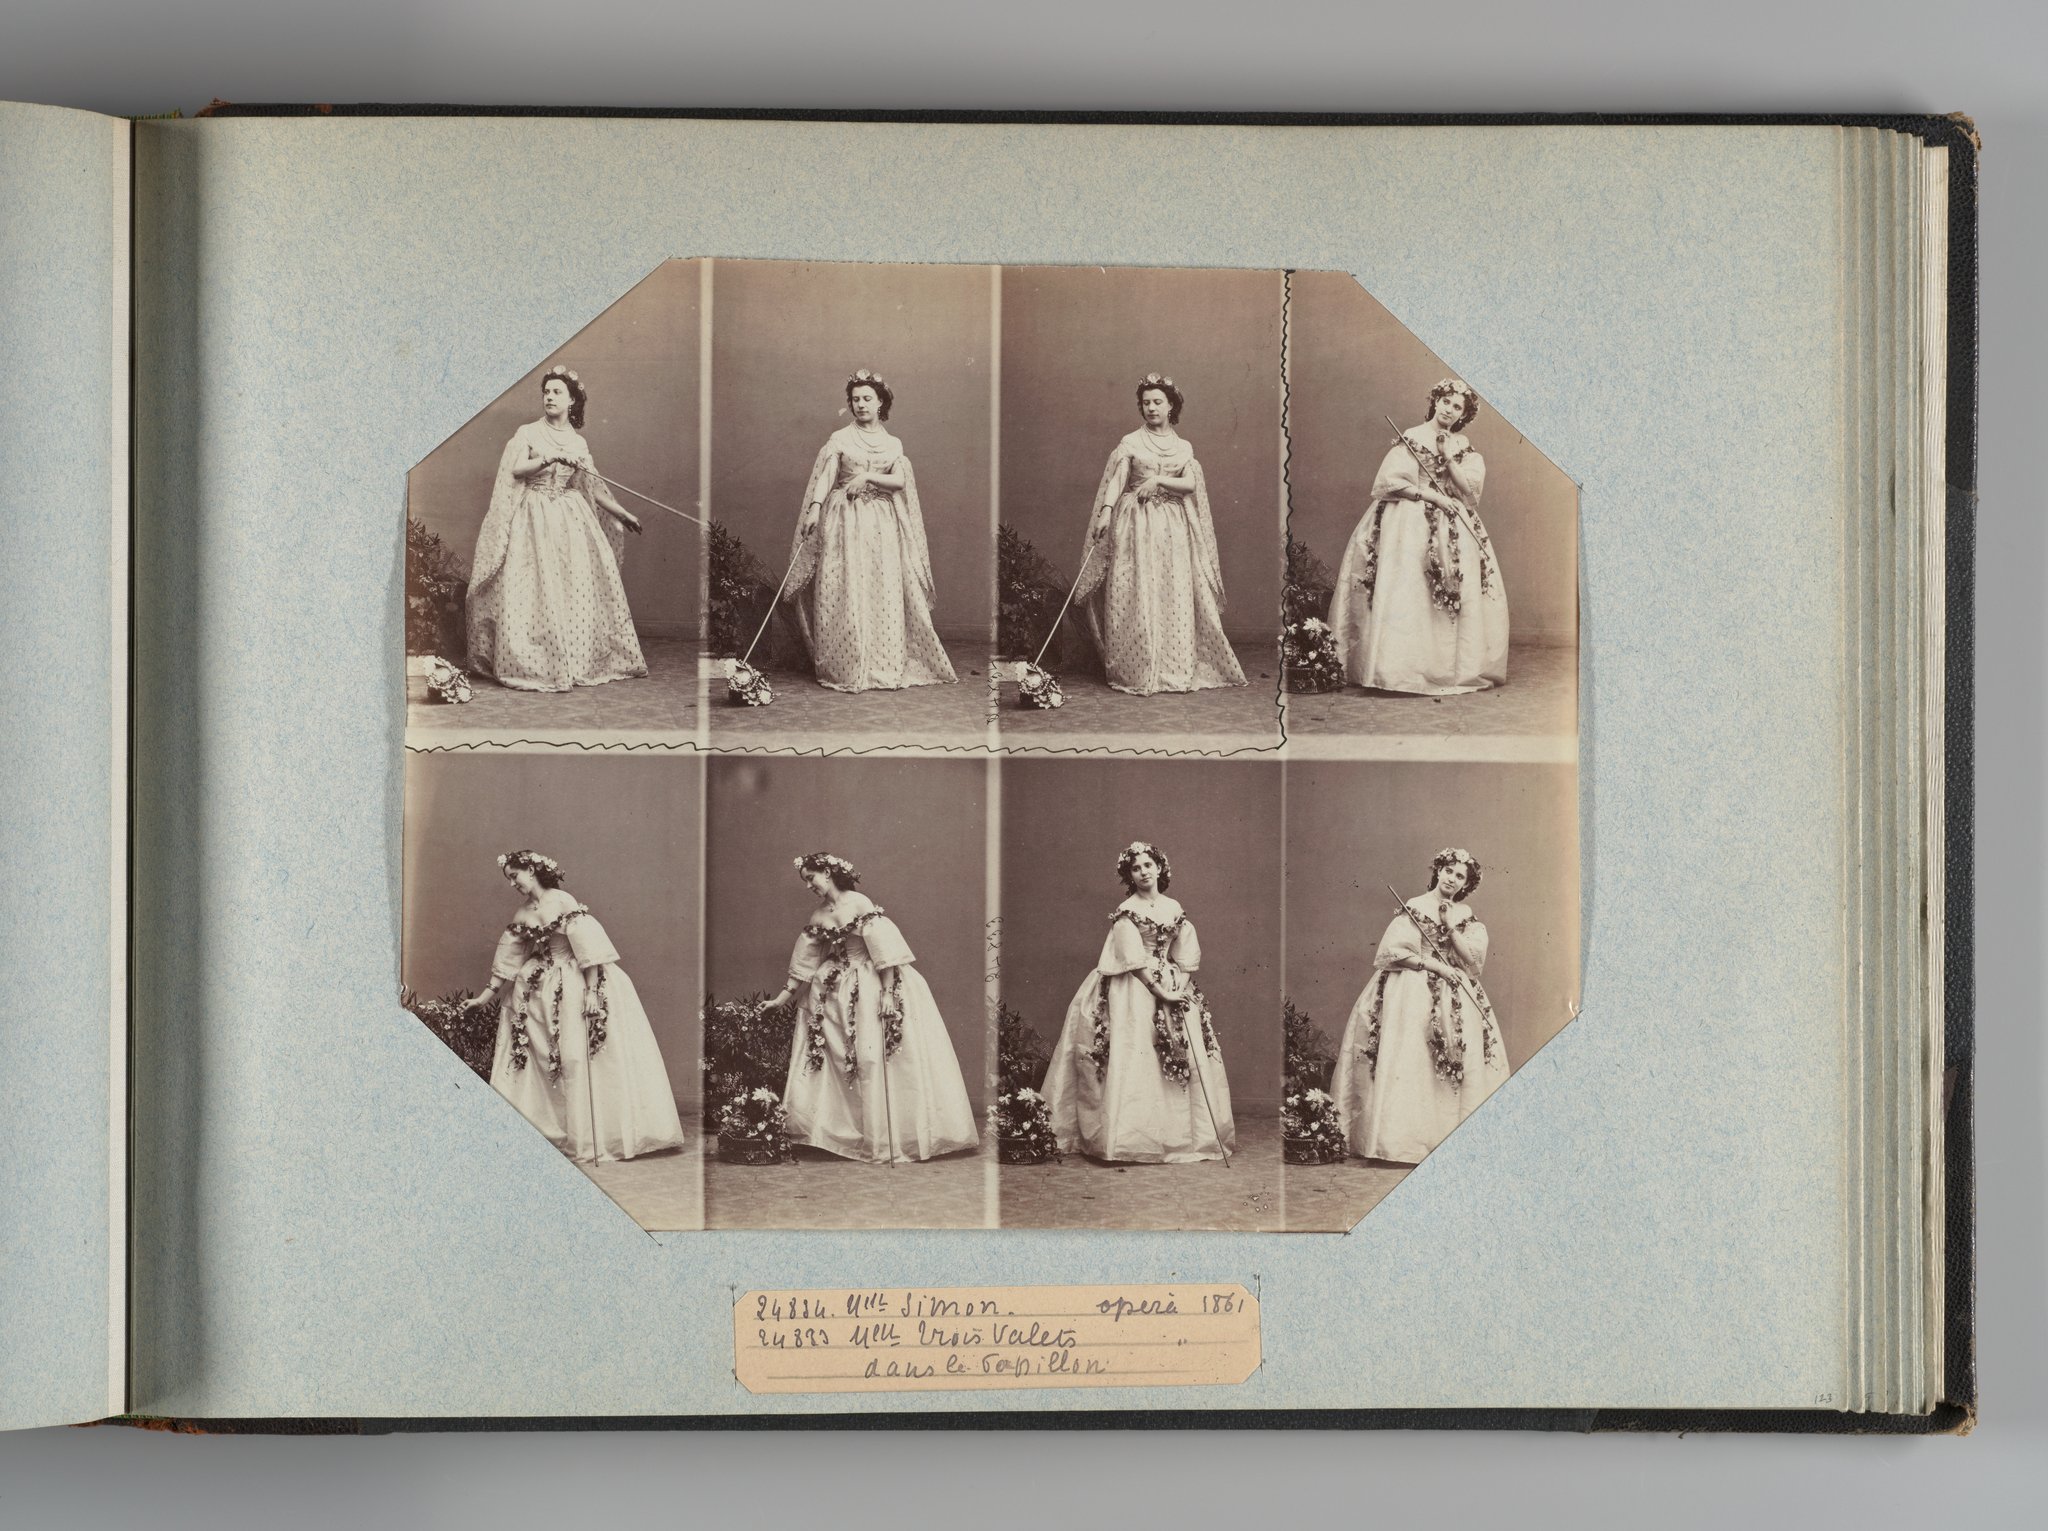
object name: photograph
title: Mlle Simon; Mlle Troisvalets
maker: andré-adolphe-eugène disdéri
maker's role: artist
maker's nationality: french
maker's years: 1819-1889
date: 1861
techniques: albumen silver print, glass negative